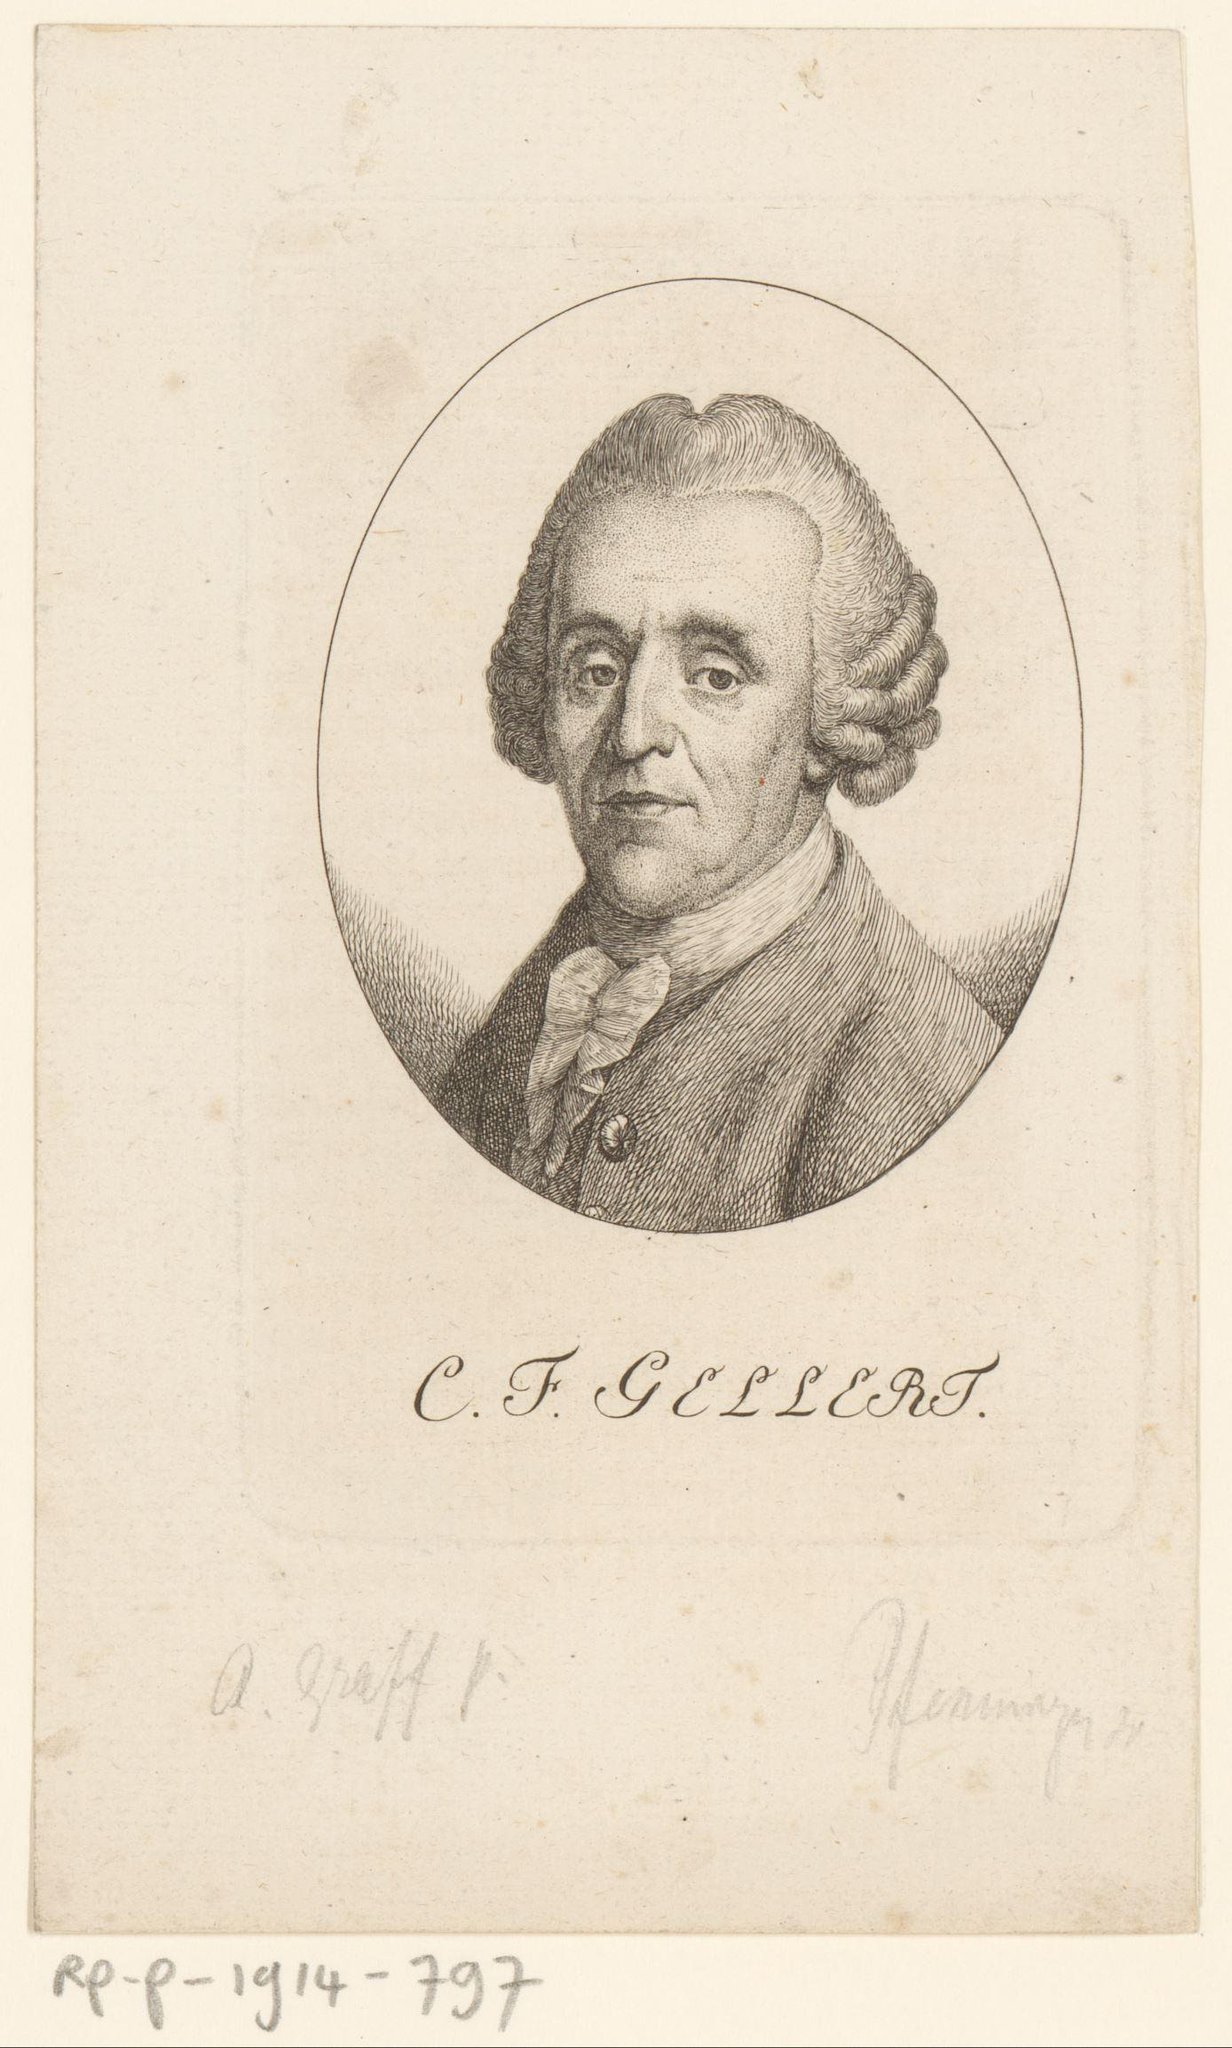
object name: print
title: Portret van Christian Fürchtegott Gellert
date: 1759-1815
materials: paper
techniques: etching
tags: historical persons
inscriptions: collector's mark: Lugt 2228, name